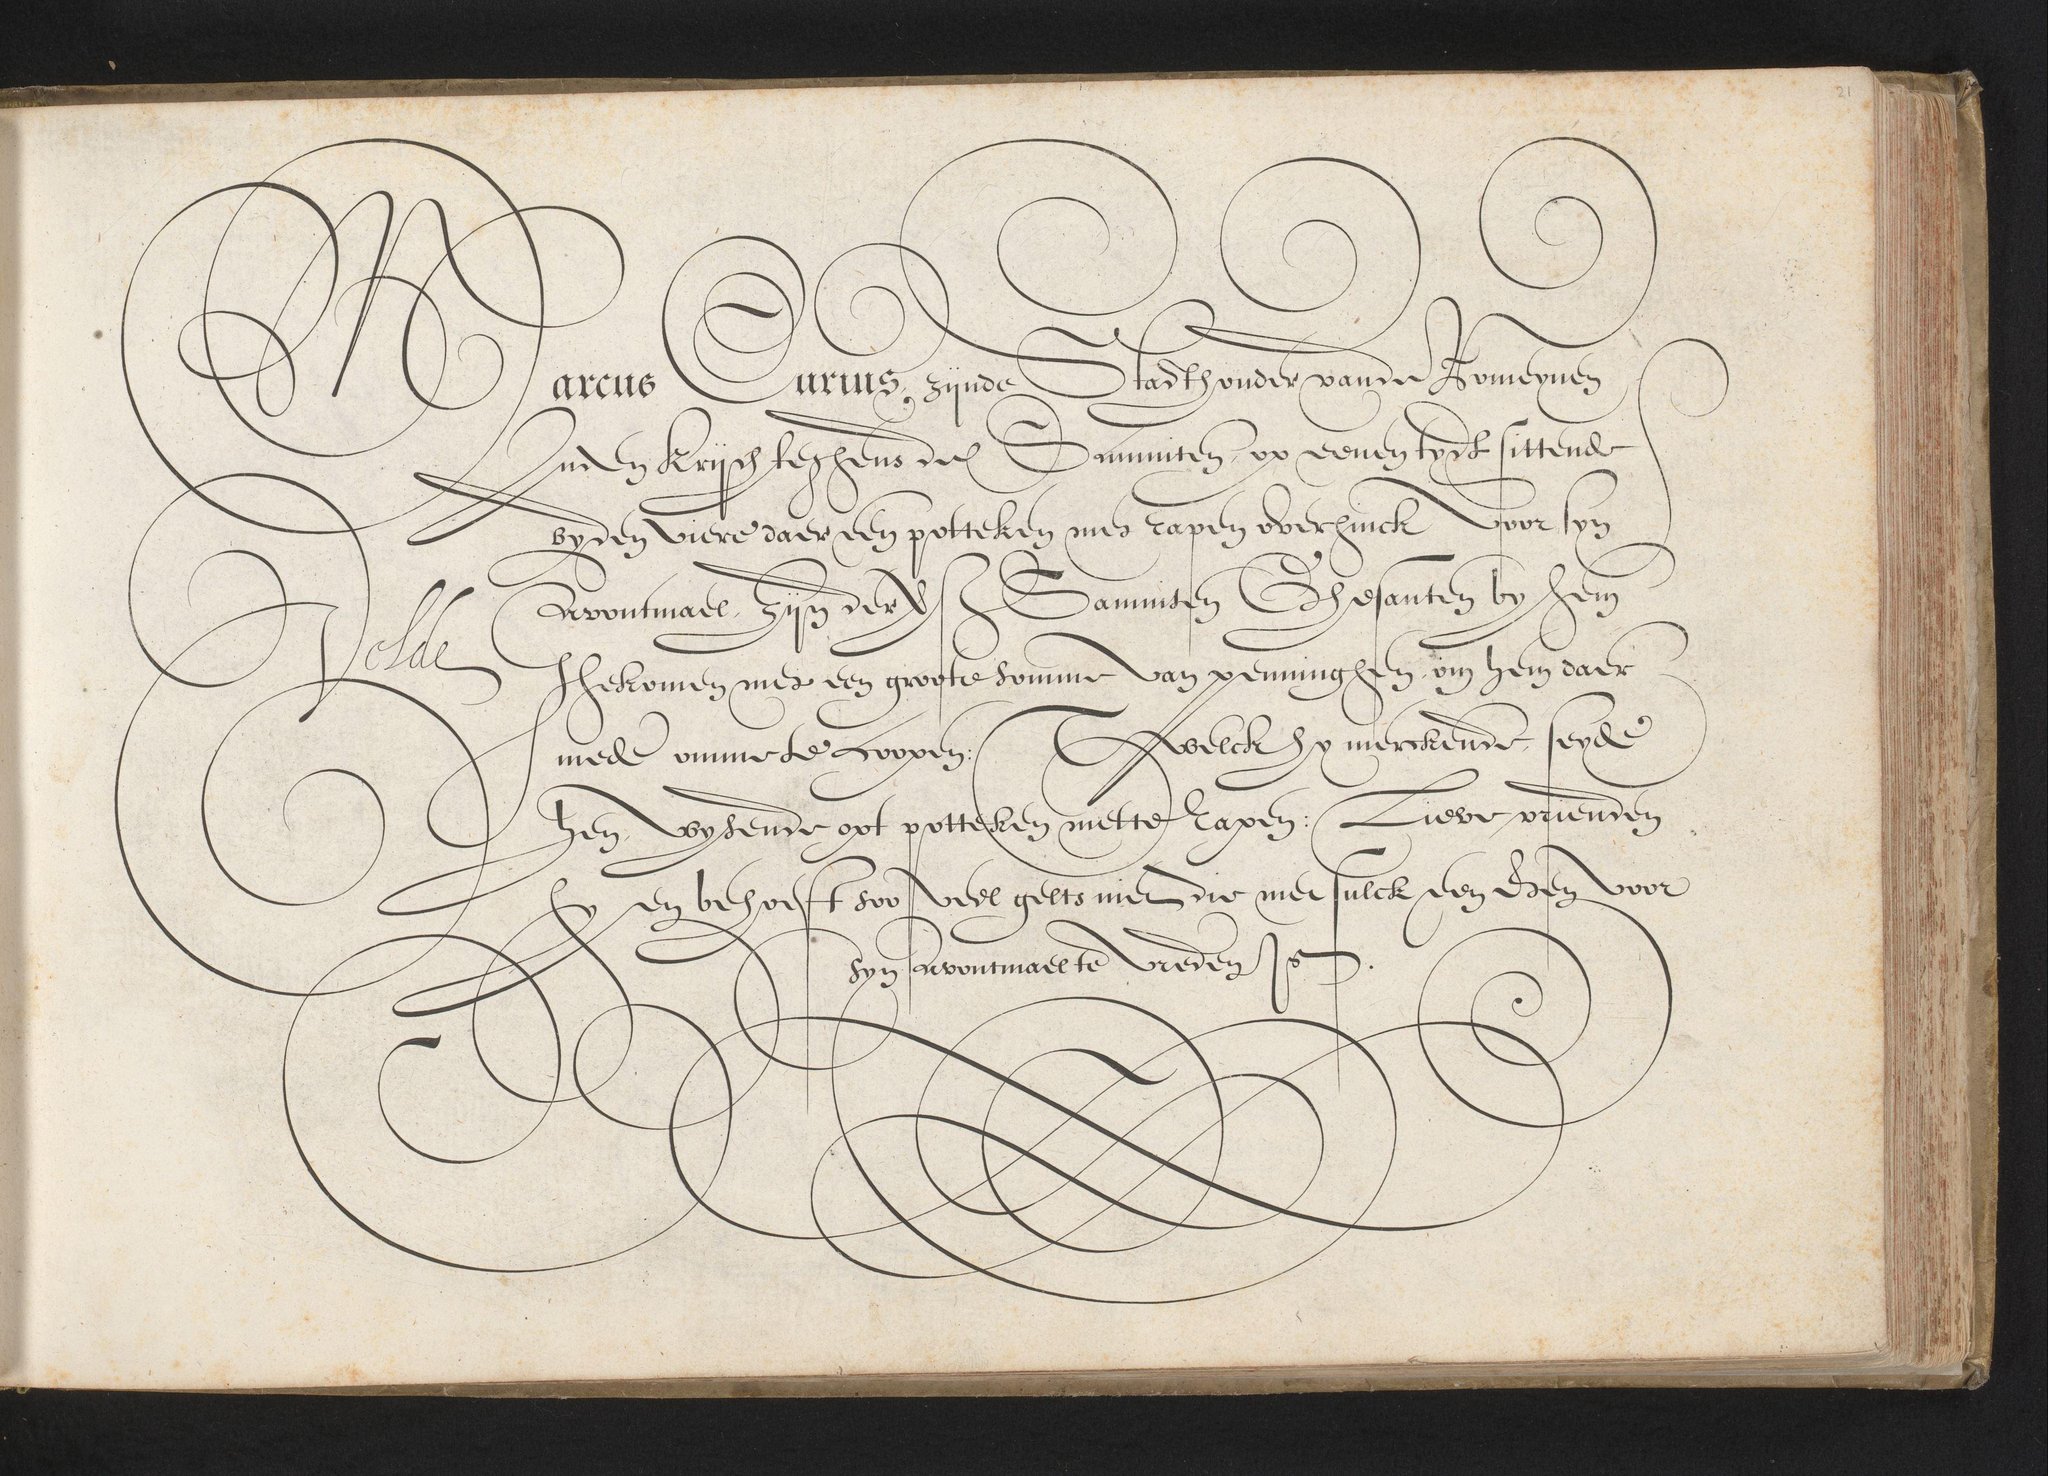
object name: print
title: Schrijfvoorbeeld: Marcus Curius (...)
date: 1605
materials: paper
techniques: engraving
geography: haarlem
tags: calligraphy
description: Schrijfvoorbeeld met negen regels tekst in het Nederlands: Marcus Curius ... avontmael te vreden. De tekst is omlijst door krulwerk. De prent maakt deel uit van een album.